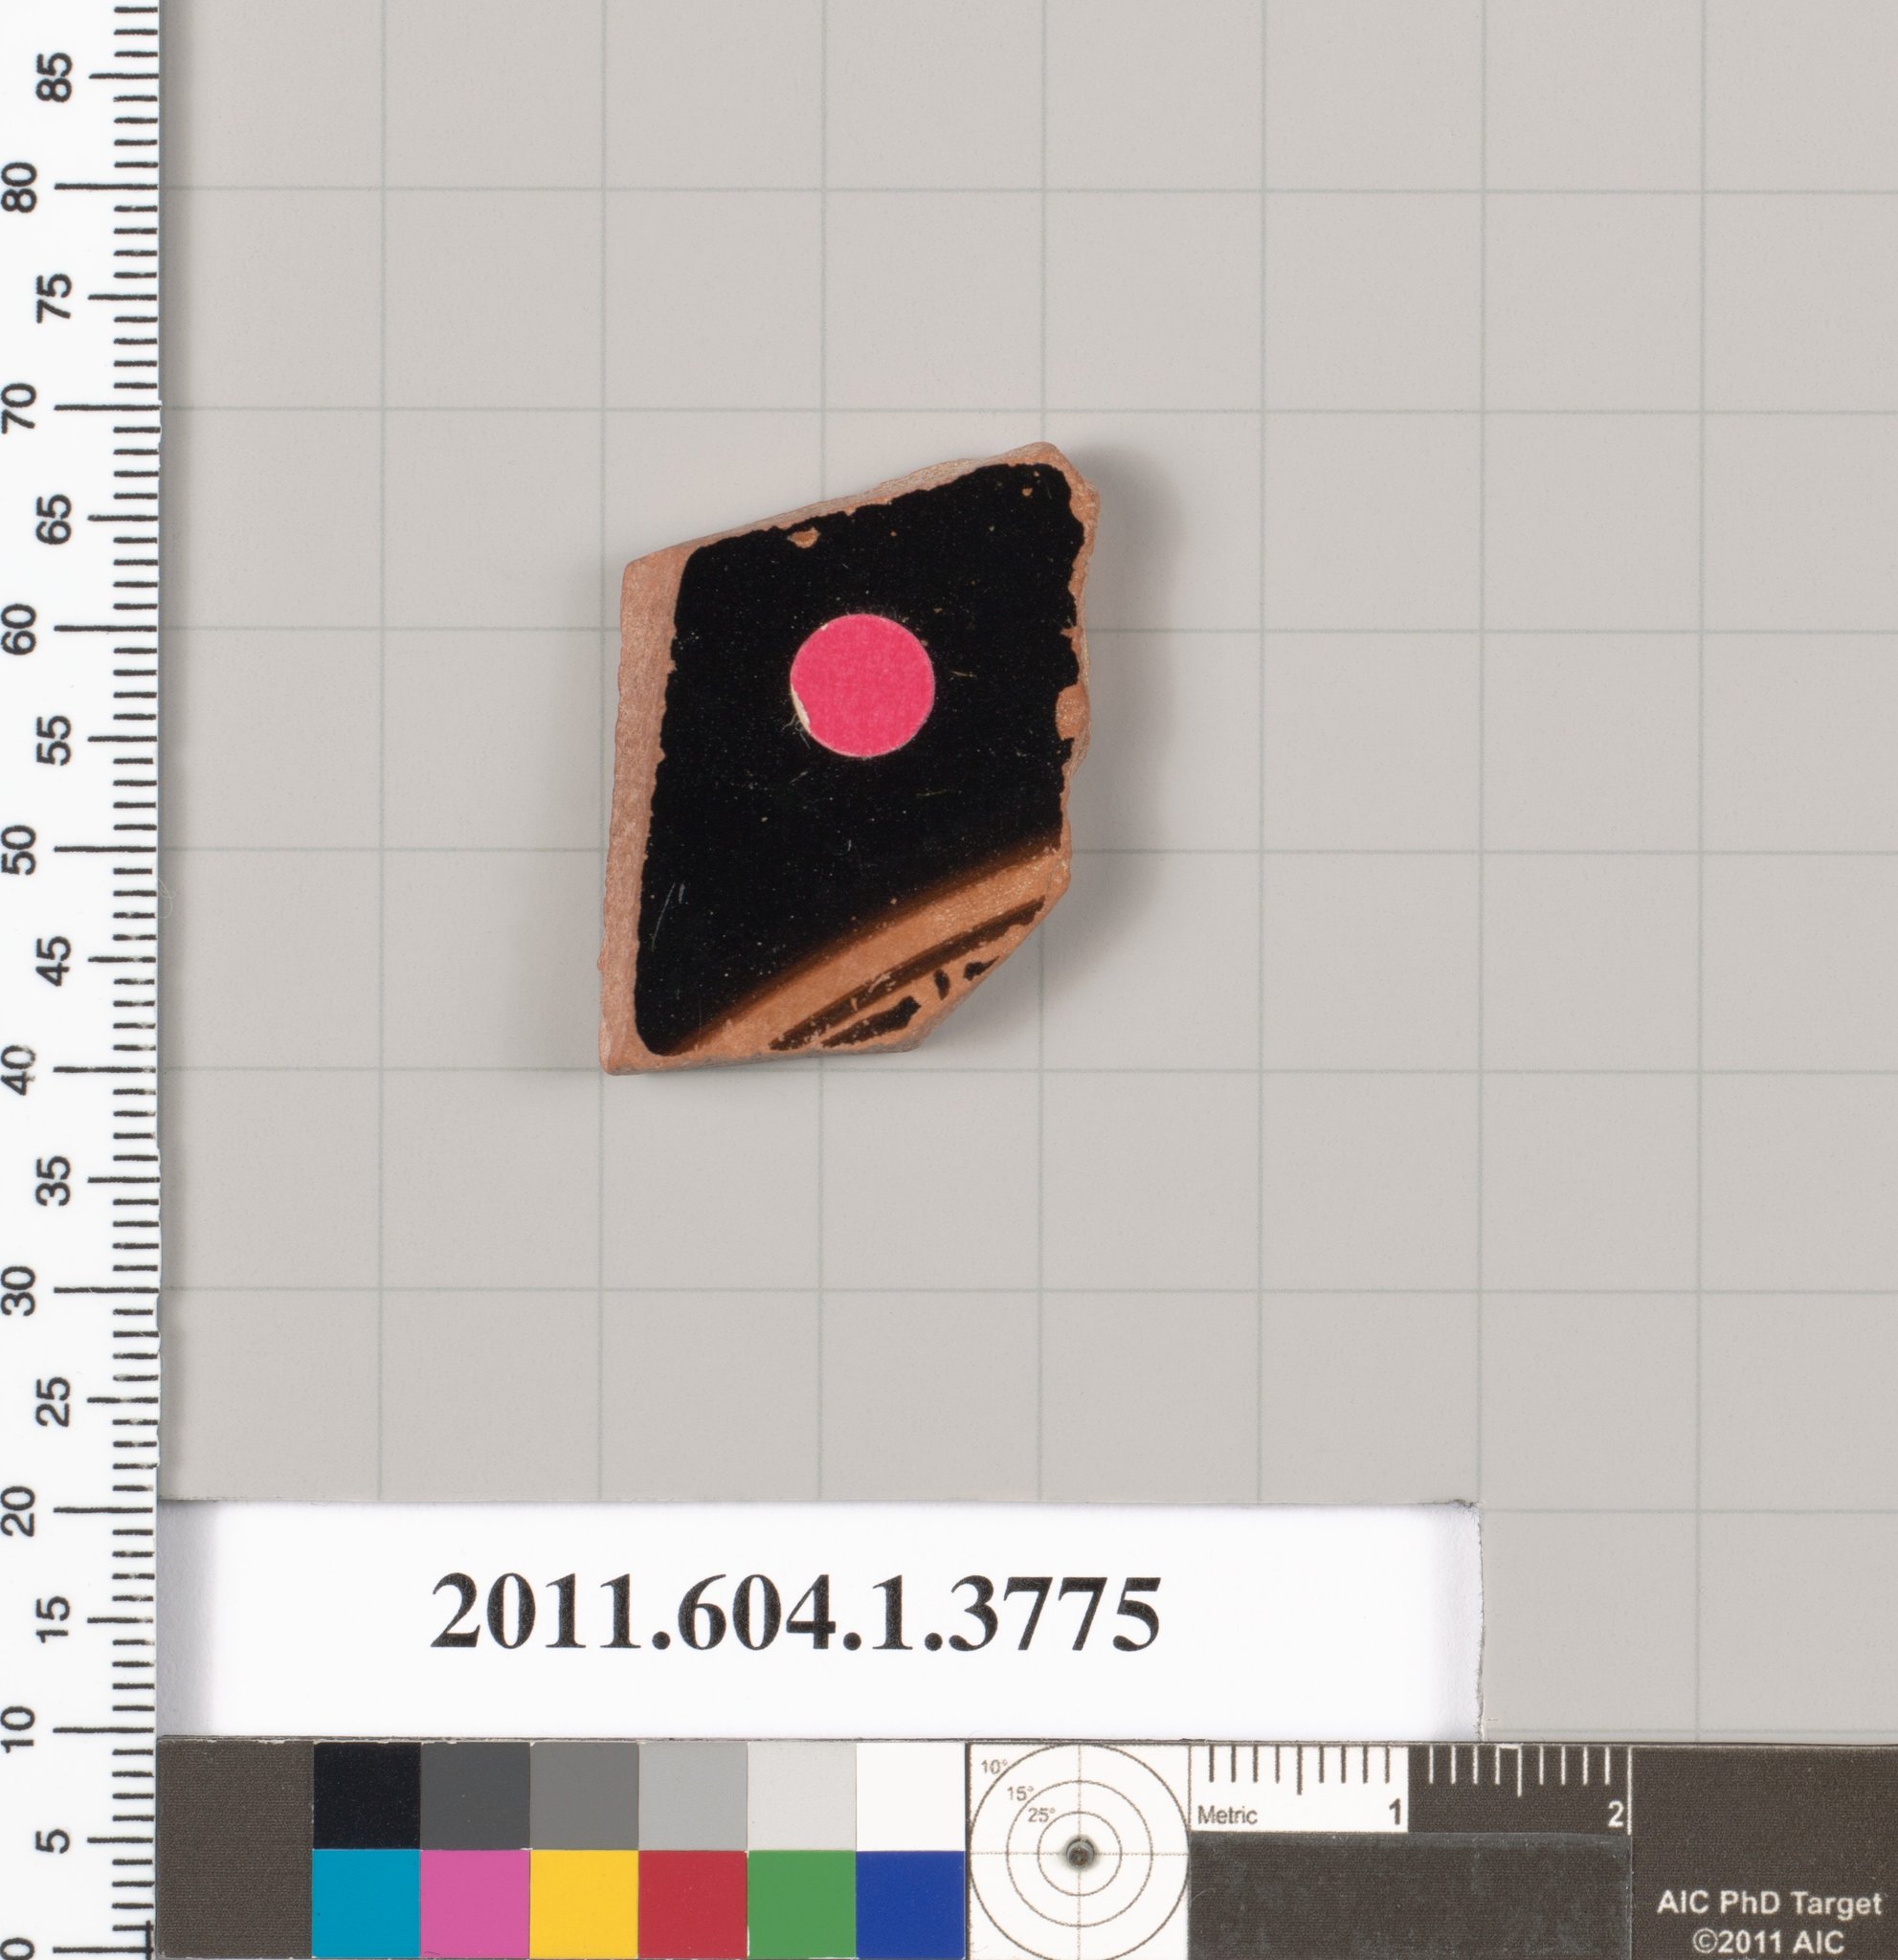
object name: kylix fragment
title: Terracotta fragment of a kylix (drinking cup)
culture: greek, attic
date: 475-451 BCE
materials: terracotta